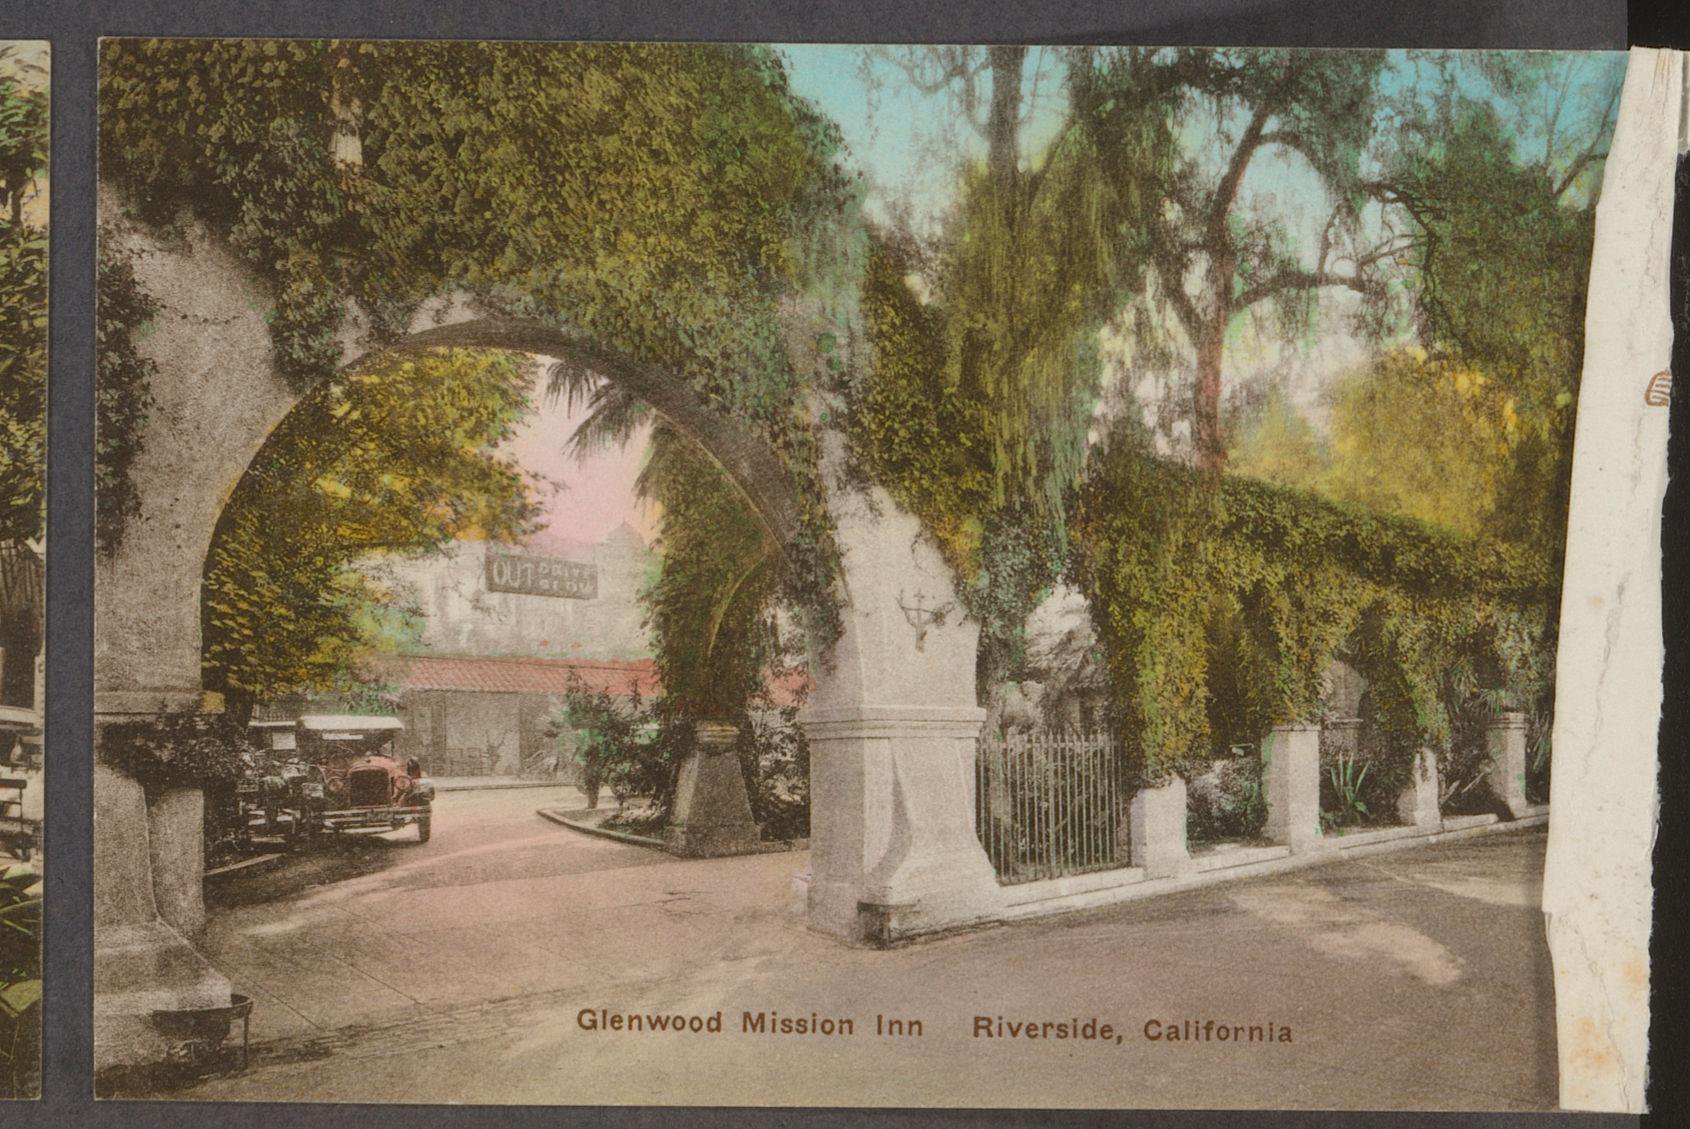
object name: album leaf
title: Glenwood Mission Inn, Riverside California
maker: Anonymous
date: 1928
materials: paper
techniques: photograph, hand coloring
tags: façade of inner court, courtyard